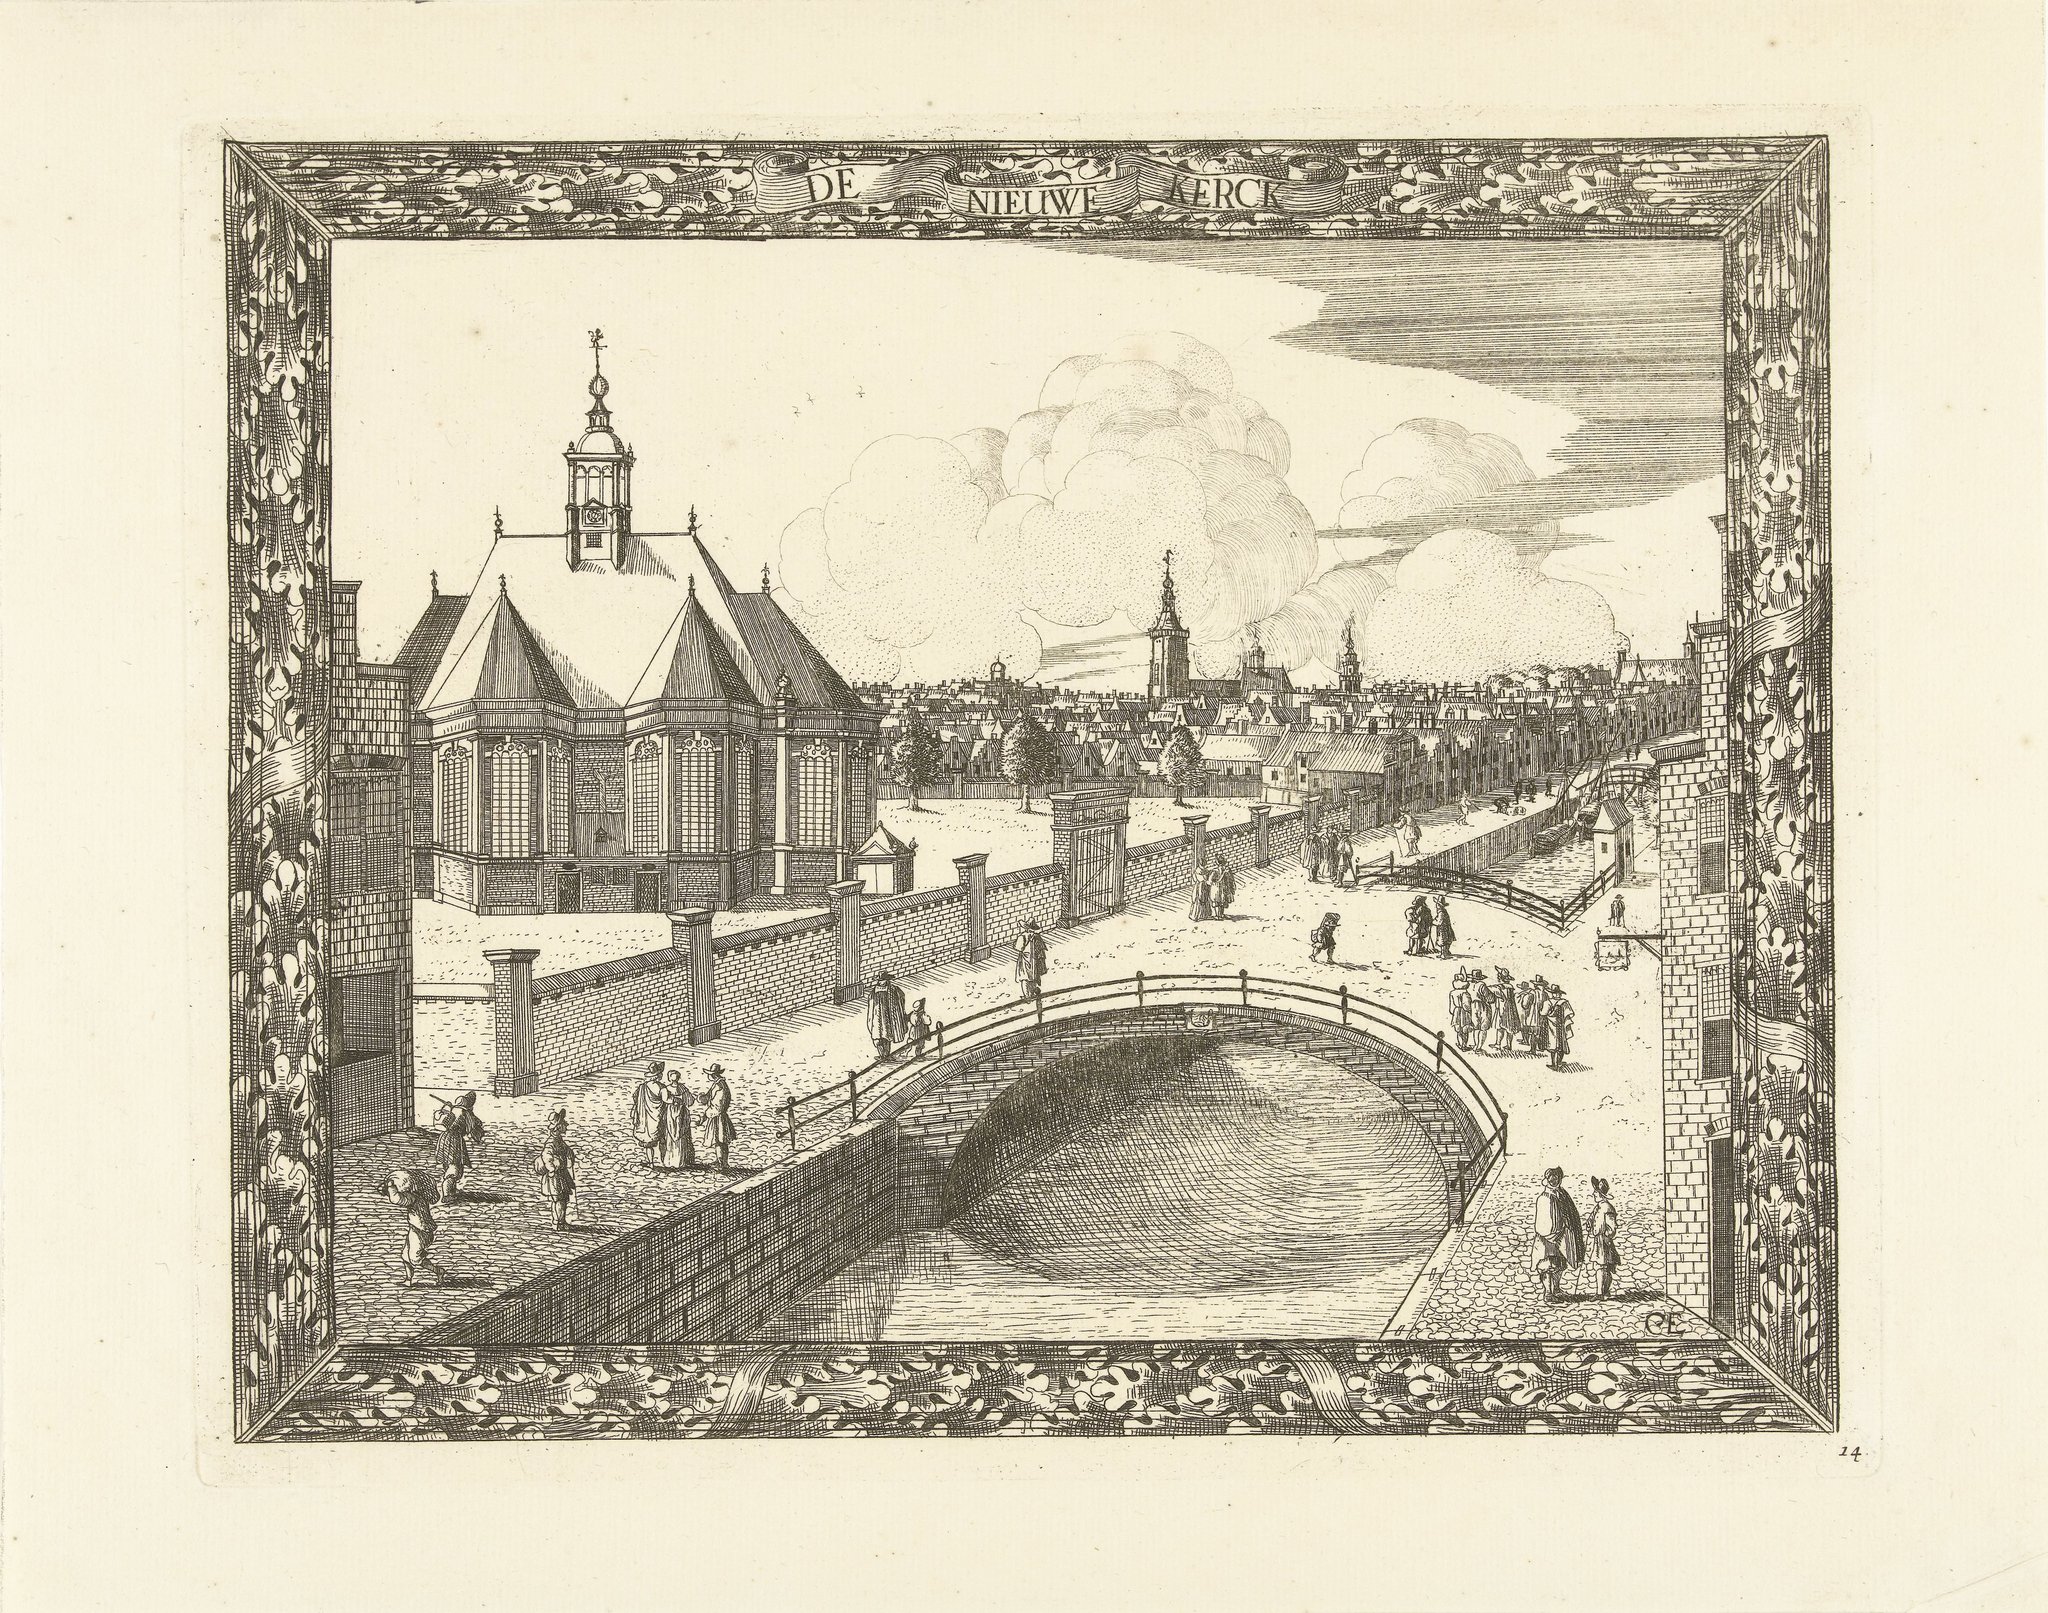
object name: print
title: Gezicht op de Nieuwe Kerk te Den Haag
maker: cornelis elandts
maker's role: draughtsman, painter, print maker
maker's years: 1641-1687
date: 1681-1728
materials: paper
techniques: etching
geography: the hague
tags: bridge in city across river, canal, etc. (+ city(-scape) with figures, staffage), church (exterior)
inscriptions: collector's mark: Lugt 2228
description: Deze prent is oorspronkelijk uitgegeven als onderdeel van de rand van de zogenaamde figuratieve kaart van Den Haag uit 1681-1682 (zie RP-P-AO-12-9D). De rand bestond uit een gezicht op de stad en veertien kleinere gezichten in en om Den Haag. Veertien van de vijftien prenten van de rand zijn later ook gebruikt in: Aa, Pieter van der. La galerie agreable du monde (...). 66 delen. Leiden: Pieter van der Aa, 1728, dl. 18 en 19. De huidige prent komt als enige niet voor in deze publicatie. Voor de overige prenten van de rand, zie: RP-P-AO-12-8, RP-P-AO-12-8-2, RP-P-OB-50.201, RP-P-OB-50.202, RP-P-OB-50.203, RP-P-OB-50.204, RP-P-OB-50.205, RP-P-OB-50.206, RP-P-OB-50.207, RP-P-OB-50.208, RP-P-OB-102.387, RP-P-OB-50.209, RP-P-OB-50.210, RP-P-OB-50.211, RP-P-OB-50.212, RP-P-OB-50.213 en RP-P-AO-12-5-4.